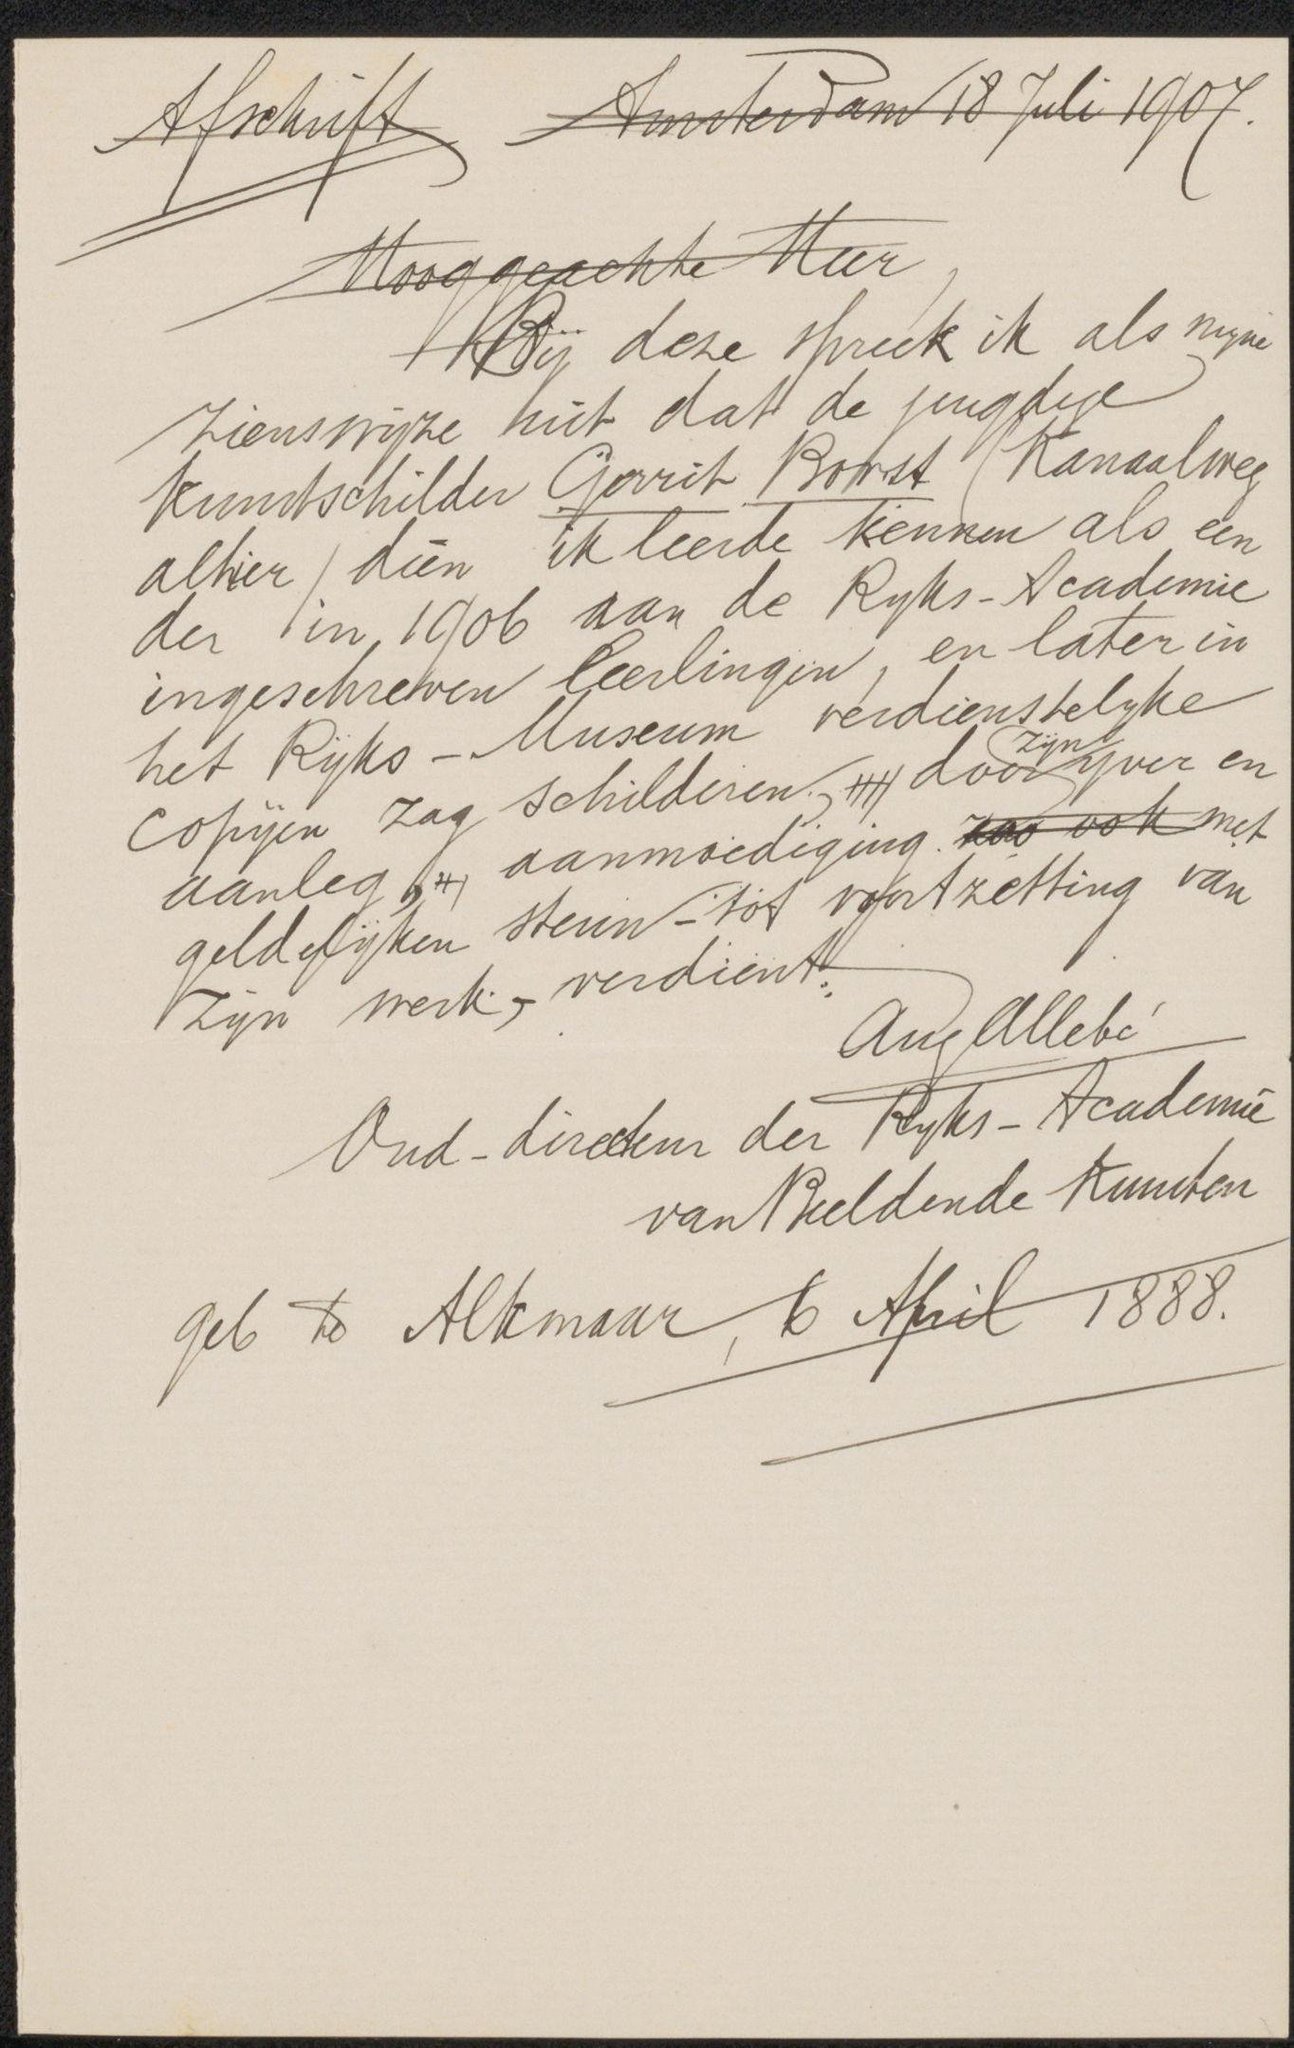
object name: letter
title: Brief aan anoniem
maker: august allebé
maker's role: draughtsman, print maker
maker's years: 1838-1927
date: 1907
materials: ink, paper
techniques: pen, writing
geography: amsterdam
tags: painter, rijksmuseum amsterdam, painting (including book-illumination, miniature-painting)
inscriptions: watermark